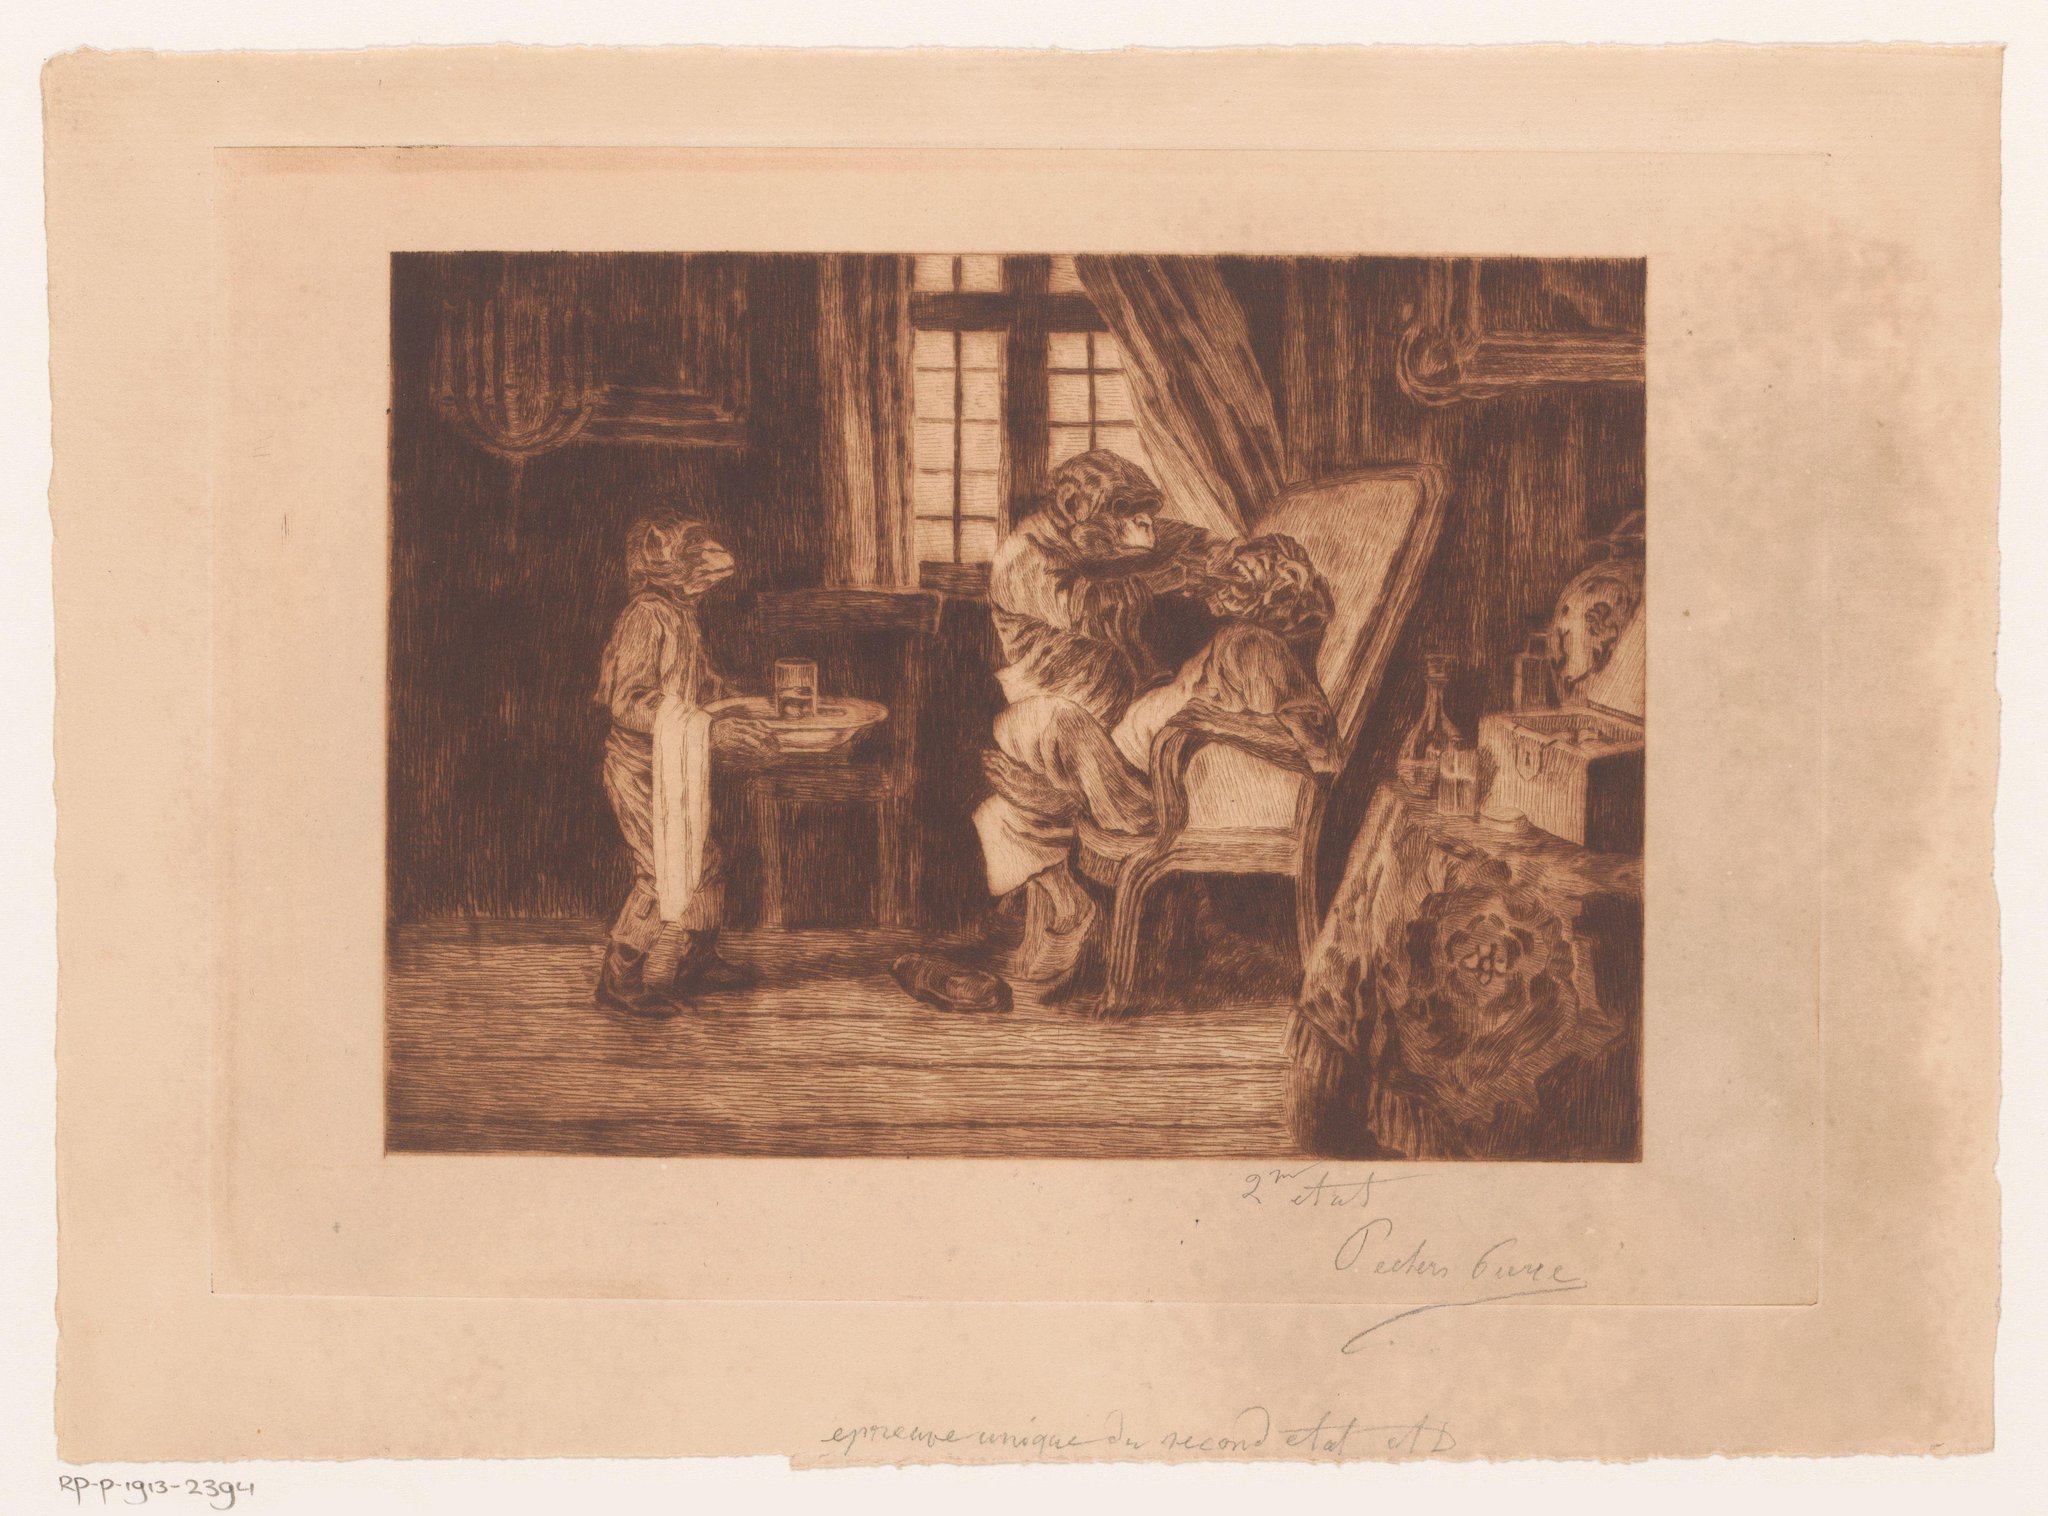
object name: print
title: Satirische voorstelling van apen als tandarts, assistent en patiënt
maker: pierre peeters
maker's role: print maker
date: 1875-1913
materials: paper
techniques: drypoint, etching, intaglio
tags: monkeys, apes, (barber as) dentist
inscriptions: annotation: ‘2em état/ [signatuur]/ epreuve unique du second etat AD [?]’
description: Geboorte- en sterfdatum van de prentmaker zijn onbekend. Daarom is voor de bepaling van de rechten van dit object gebruik gemaakt van de verwervingsdatum Rijksmuseum Amsterdam.